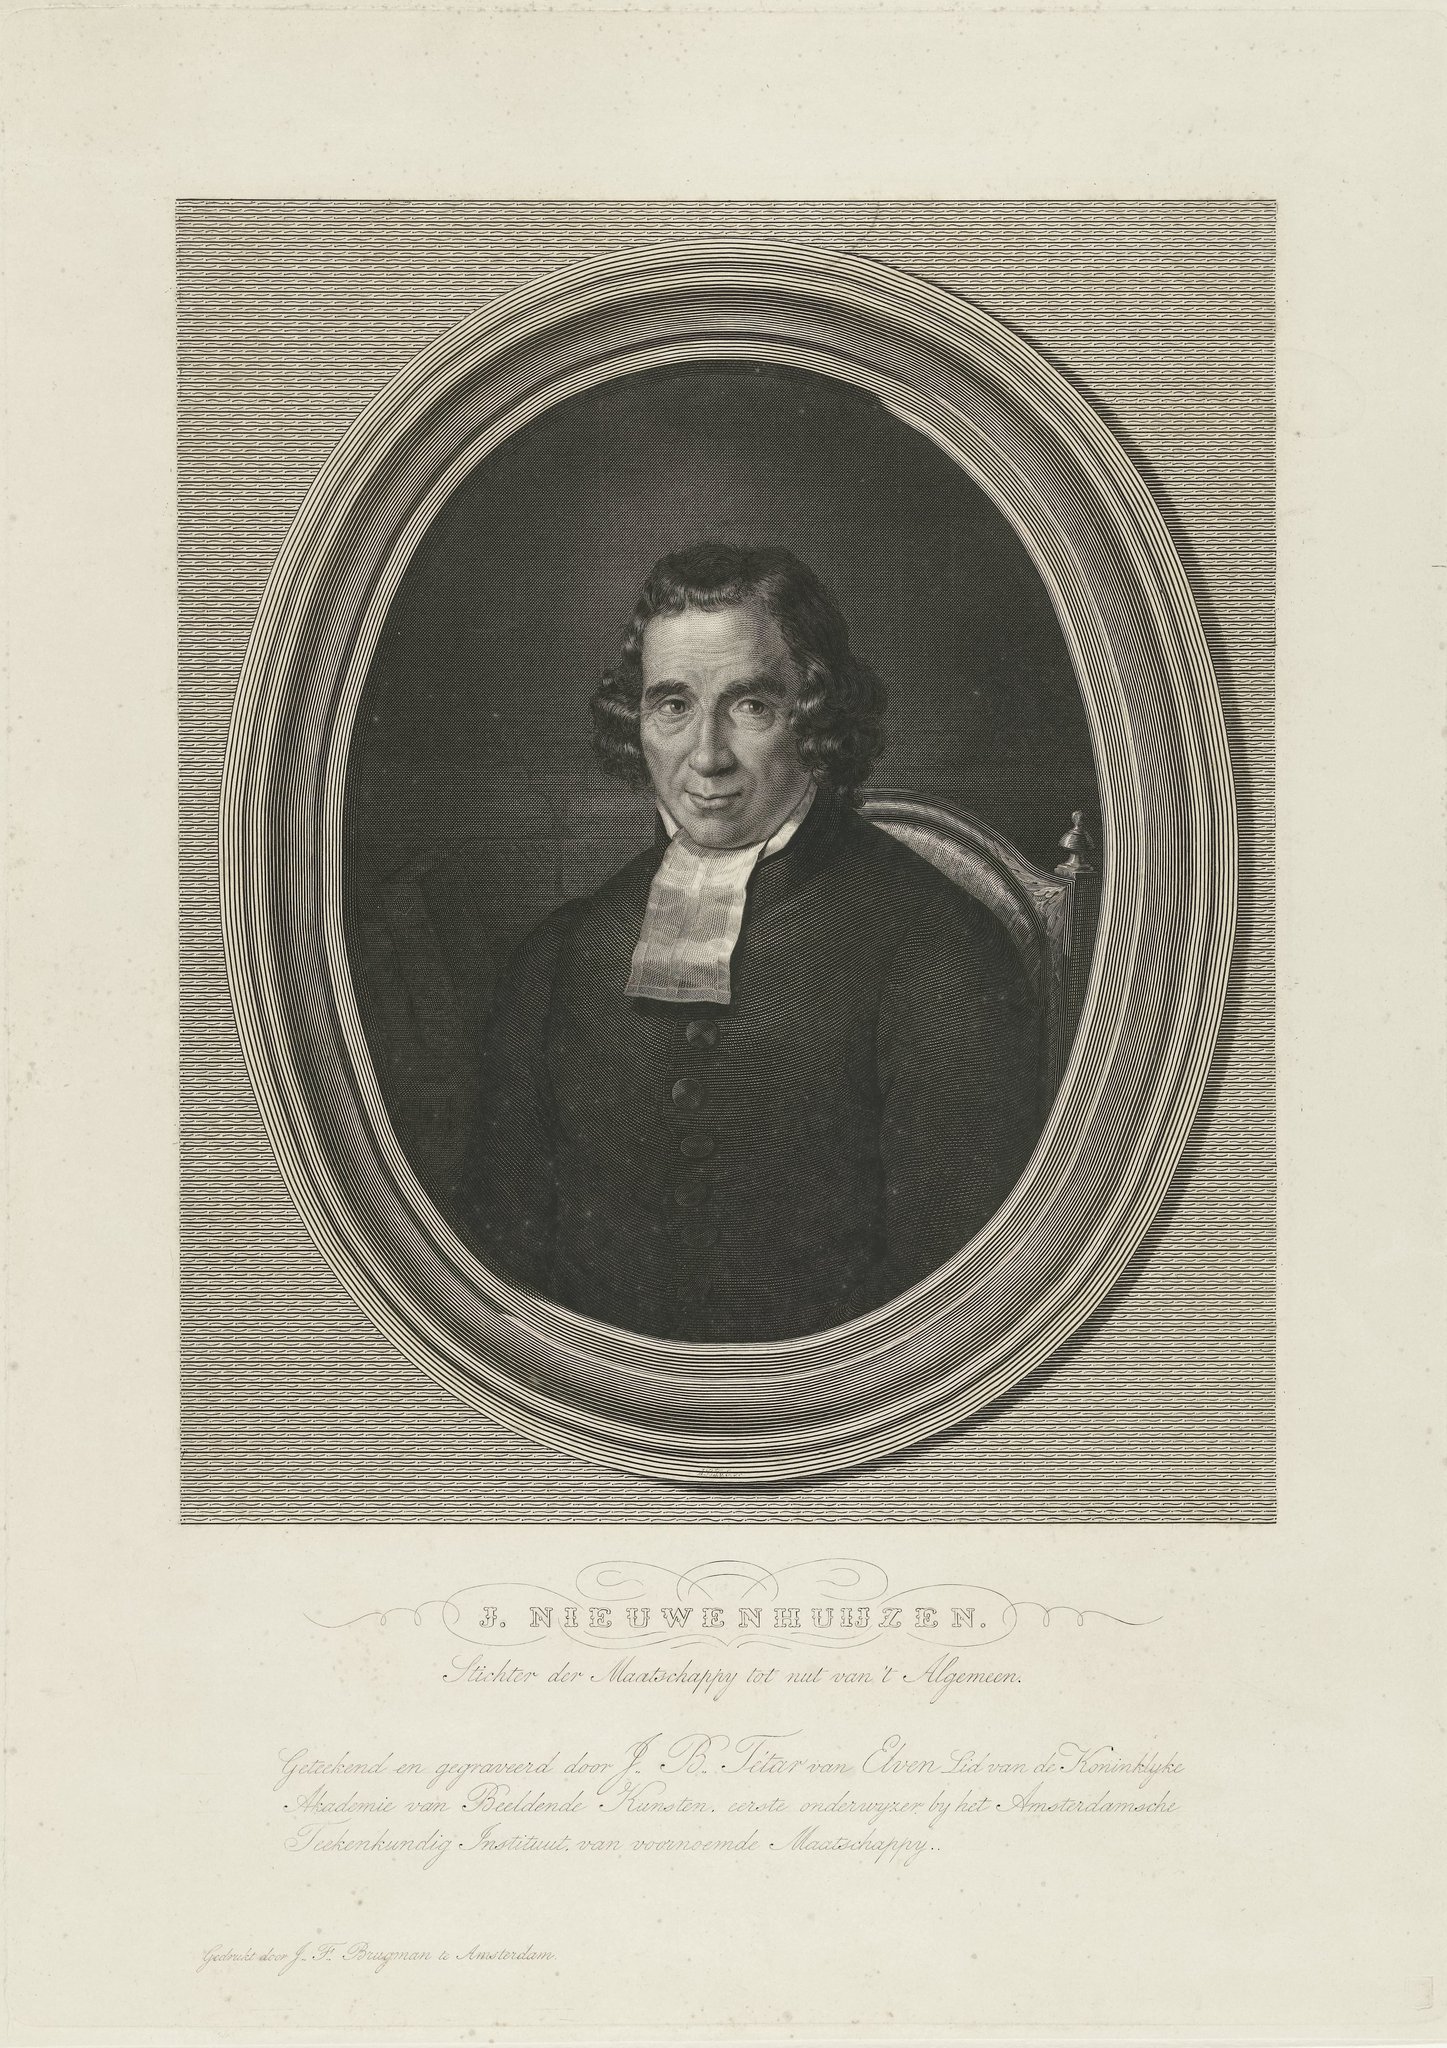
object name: print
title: Portret van Jan Nieuwenhuijzen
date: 1845-1853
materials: paper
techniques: engraving, etching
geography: amsterdam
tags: haarlem, amsterdam, jan nieuwenhuyzen, historical persons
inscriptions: collector's mark: Lugt 2228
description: Portret van Jan Nieuwenhuijzen (1724-1806), doopsgezinde predikant te Monnickendam en oprichter van de Maatschappij tot Nut van 't Algemeen. Nieuwenhuijzen is ten halven lijve, zittend op een stoel afgebeeld in een ovale omlijsting. Onder de voorstelling vijf regels Nederlandse tekst.